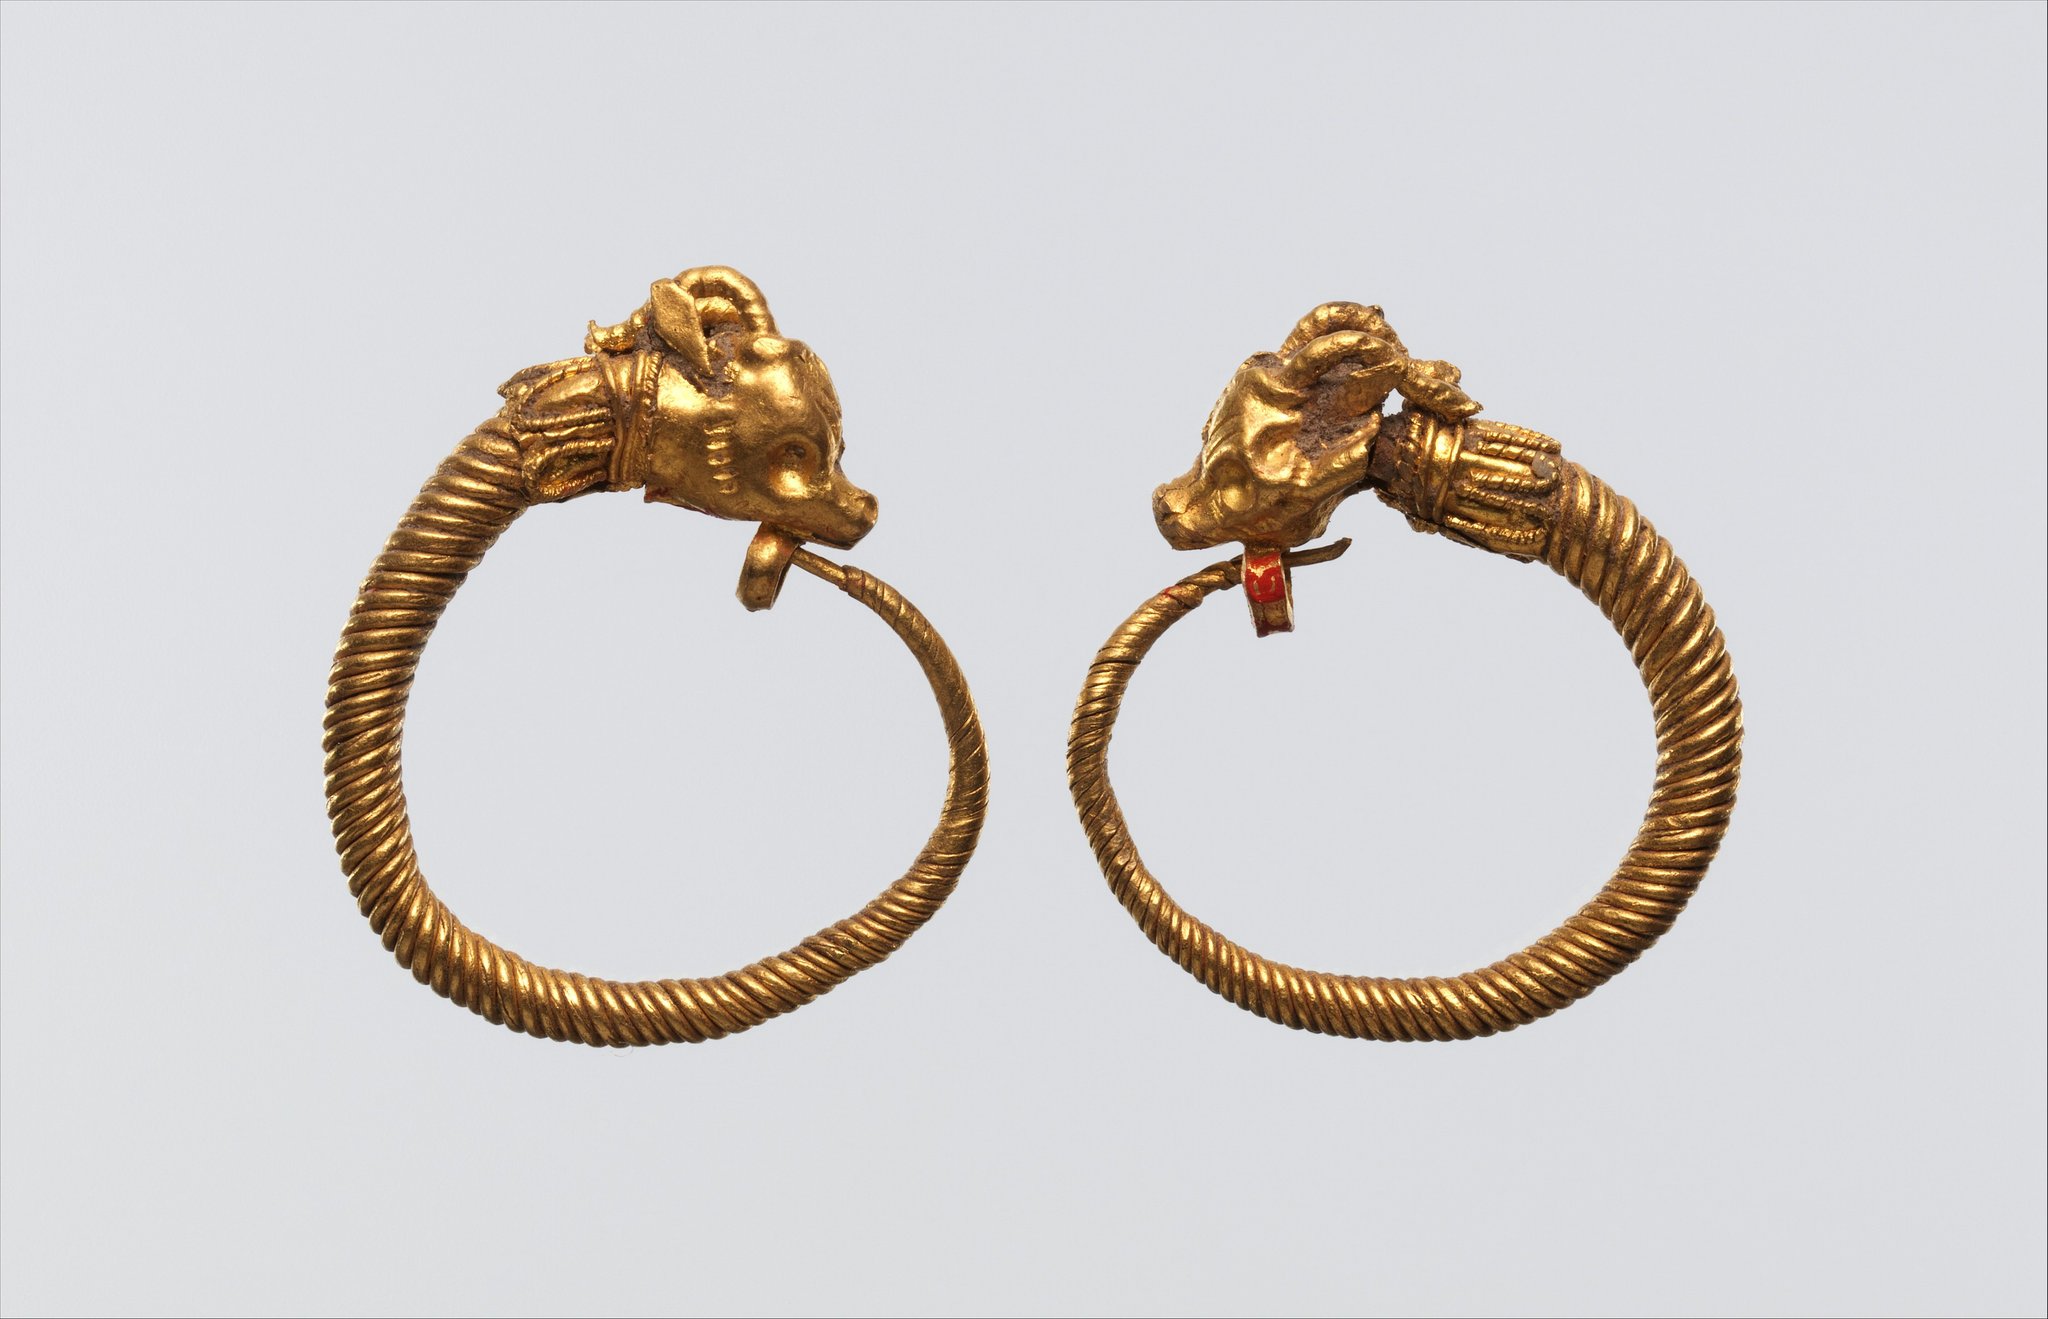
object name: earring, ibex head terminal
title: Earrings with ibex head terminal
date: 400-201 BCE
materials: gold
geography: egypt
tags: ibex